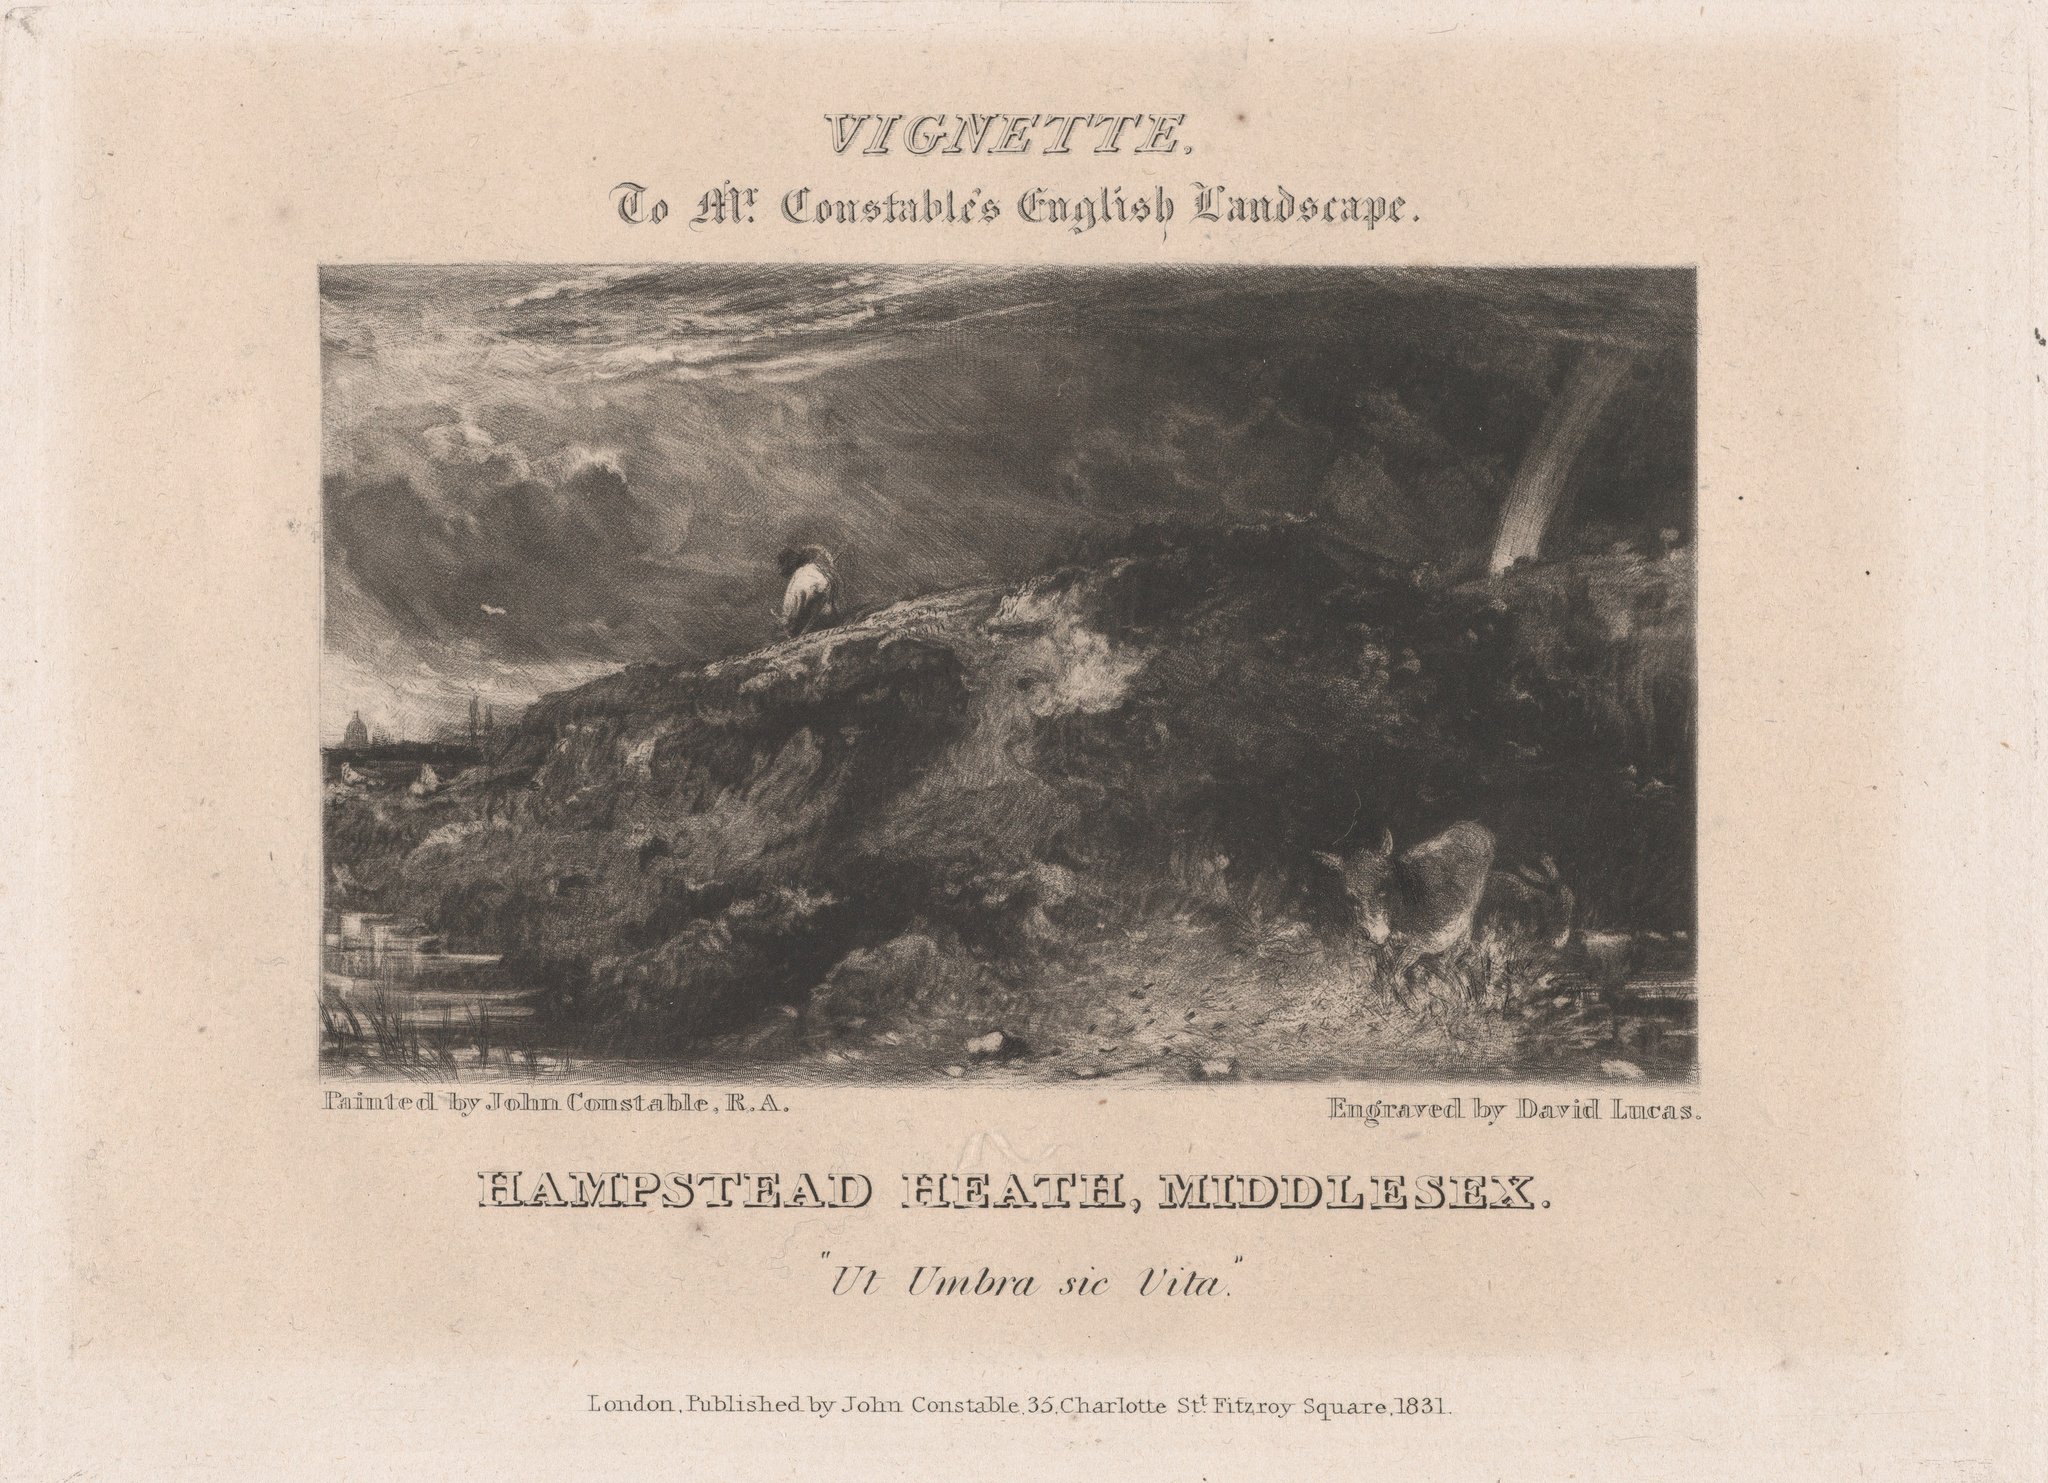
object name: print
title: Hampstead Heath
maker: david lucas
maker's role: artist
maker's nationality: british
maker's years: 1802-1881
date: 1829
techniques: mezzotint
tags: animals,storms